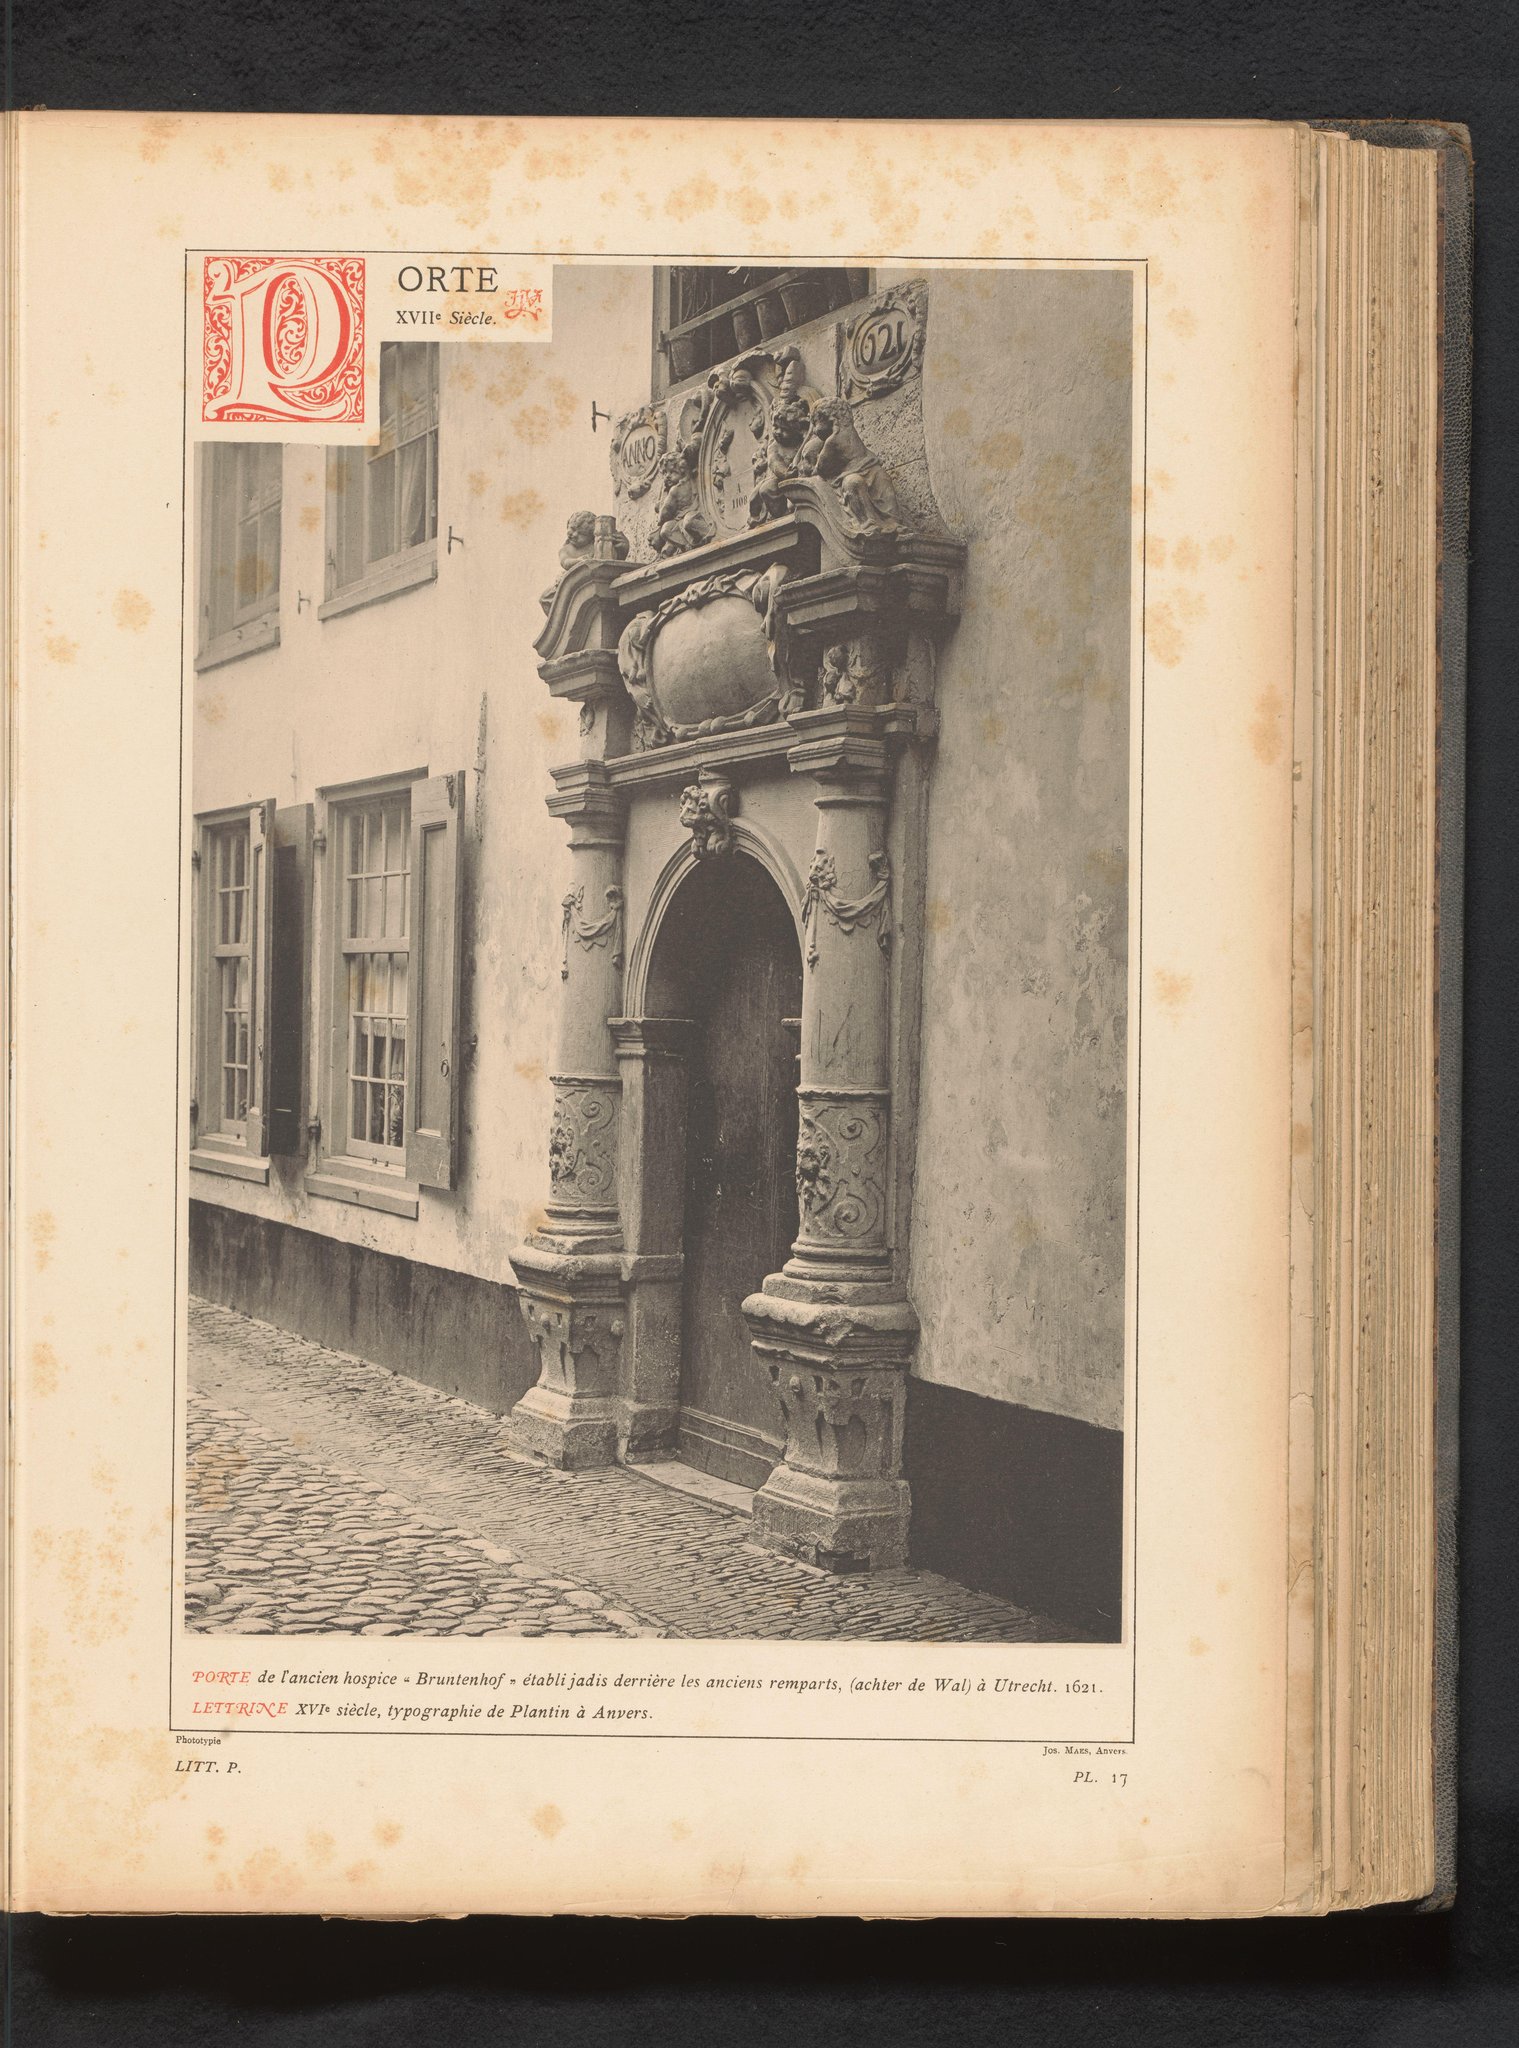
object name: photomechanical print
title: Porte, XVIIe Siècle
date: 1876-1881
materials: paper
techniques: photograph, photolithography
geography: antwerp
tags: door, civic architecture; edifices; dwellings, utrecht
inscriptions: inscription: ‘LITT. P. - PL. 17.’, monogram: ‘JJvY’, inscription: ‘PORTE de l'ancien (...)’